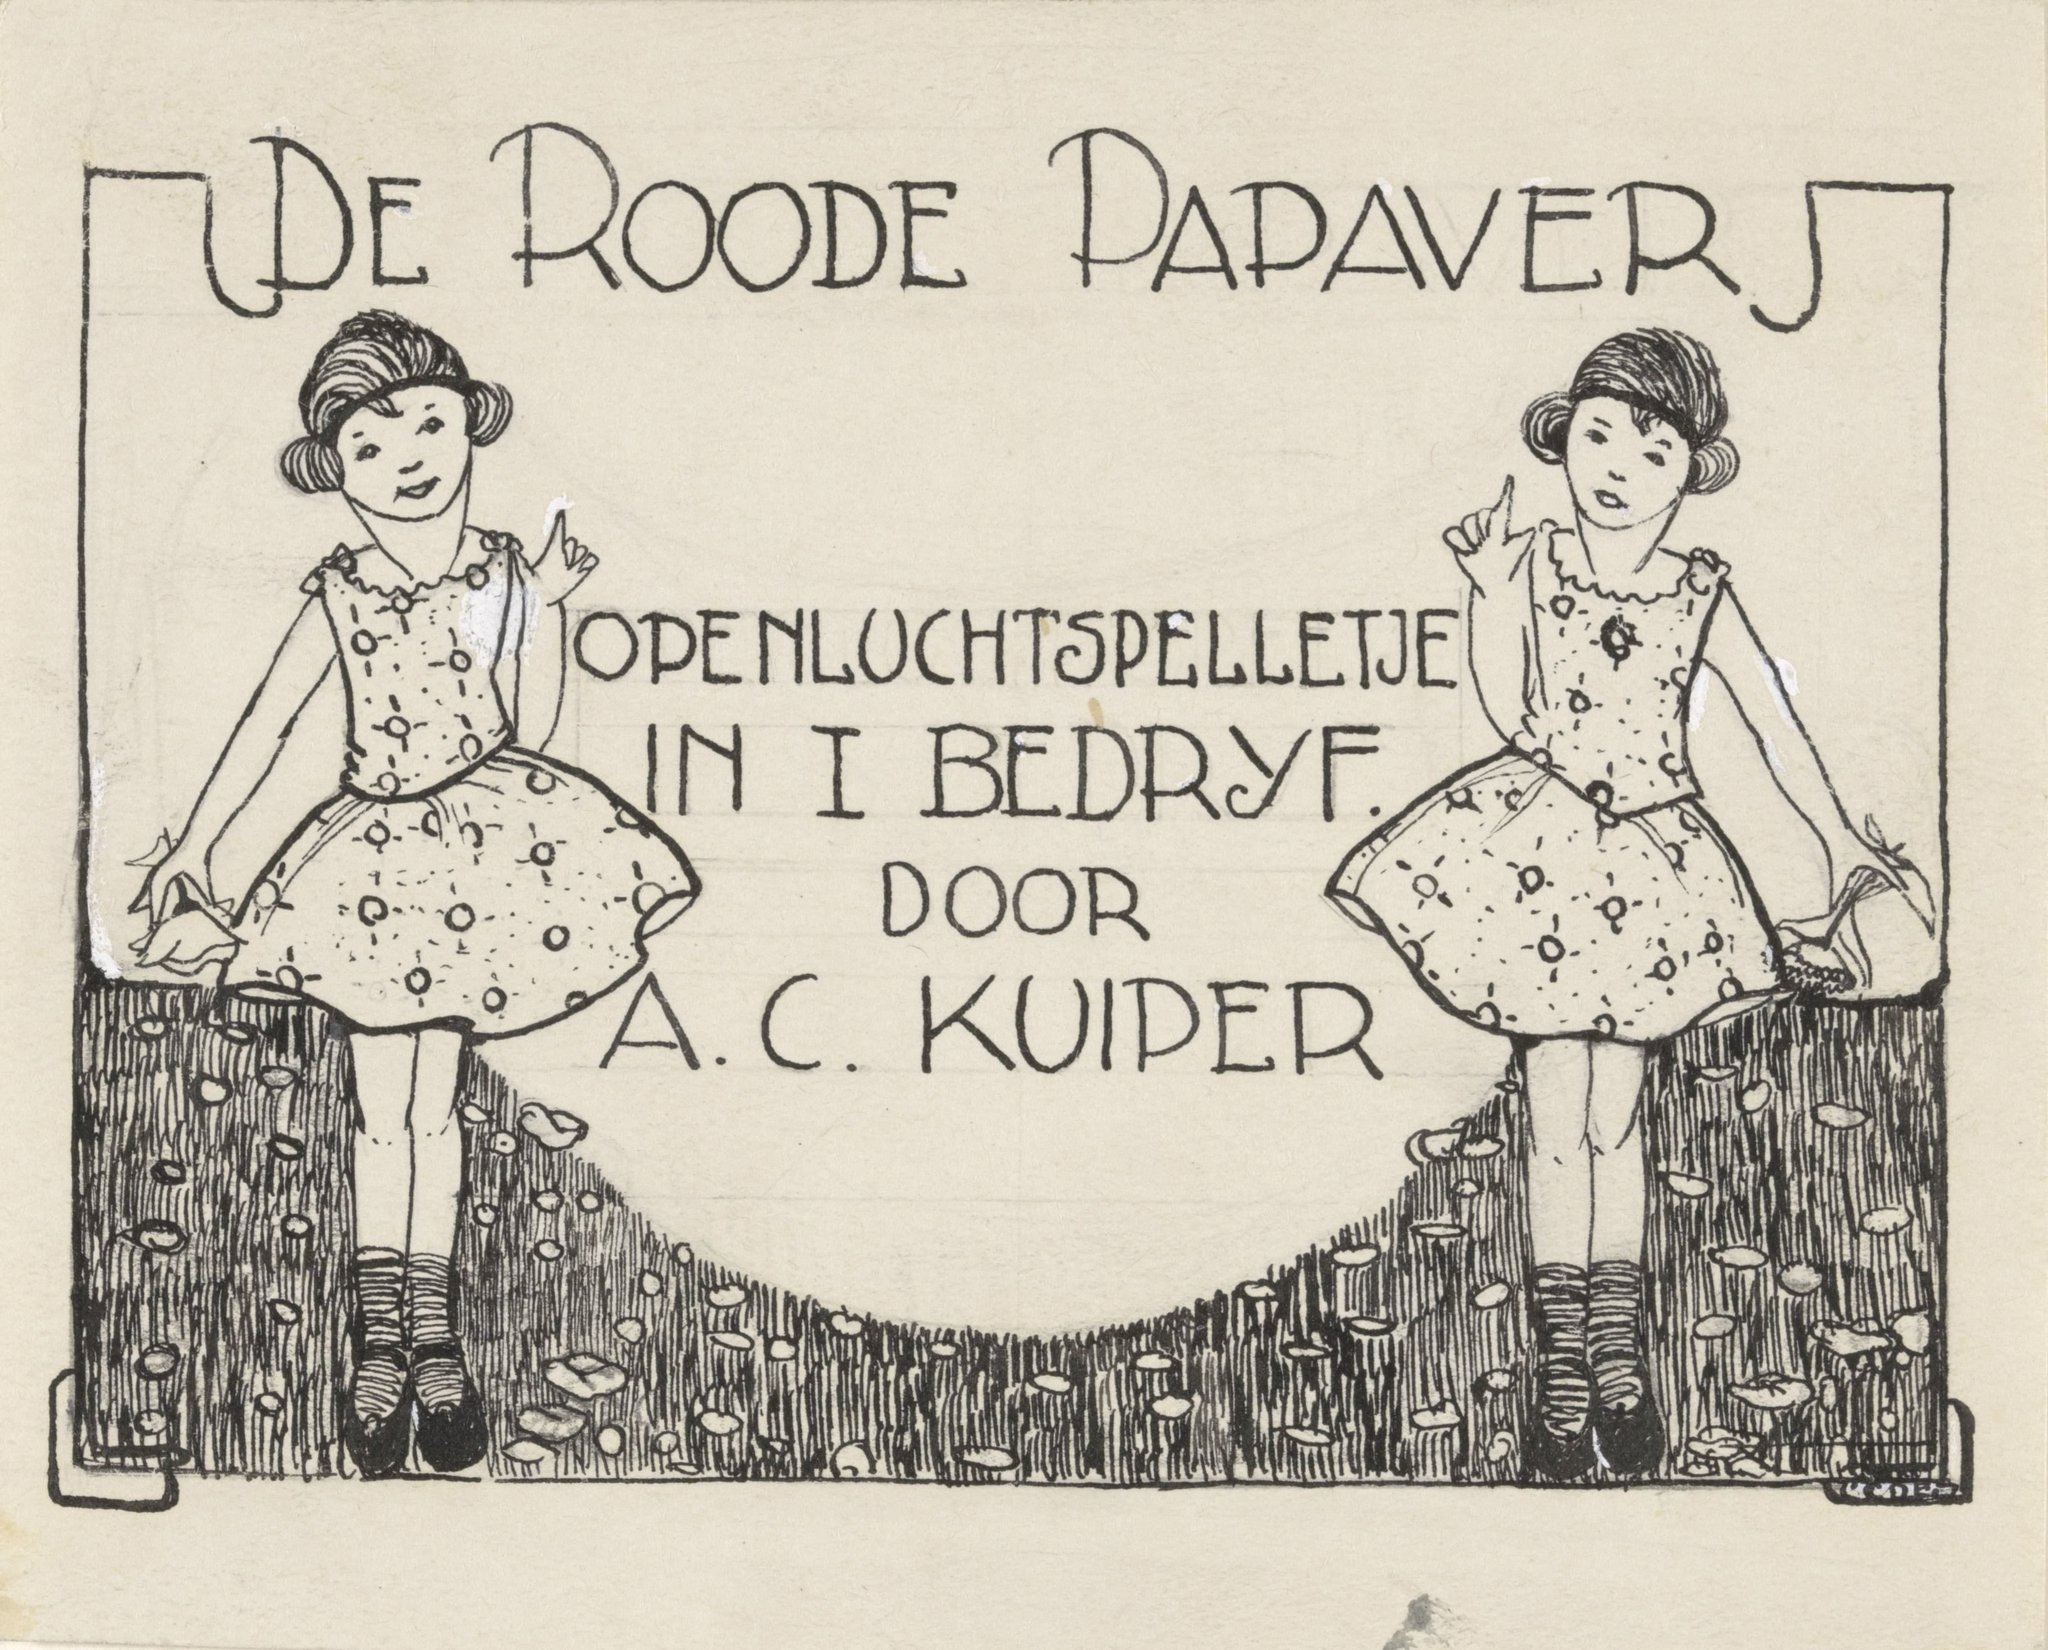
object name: drawing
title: Twee meisjes in een papaverveld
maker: c. goes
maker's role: draughtsman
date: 1910-1940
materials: paint, ink, paper, pencil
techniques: brush, pen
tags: arm raised upward, girl (child between toddler and youth), flowers: poppy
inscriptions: signature: ‘C GOES’, :, collector's mark: Lugt 2228a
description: Twee meisjes gekleed in korte jurken staan in een papaverveld. Elk heeft een bloem in de ene hand en houdt de andere hand omhoog. Verso een potloodtekening van het gezicht van een meisje.